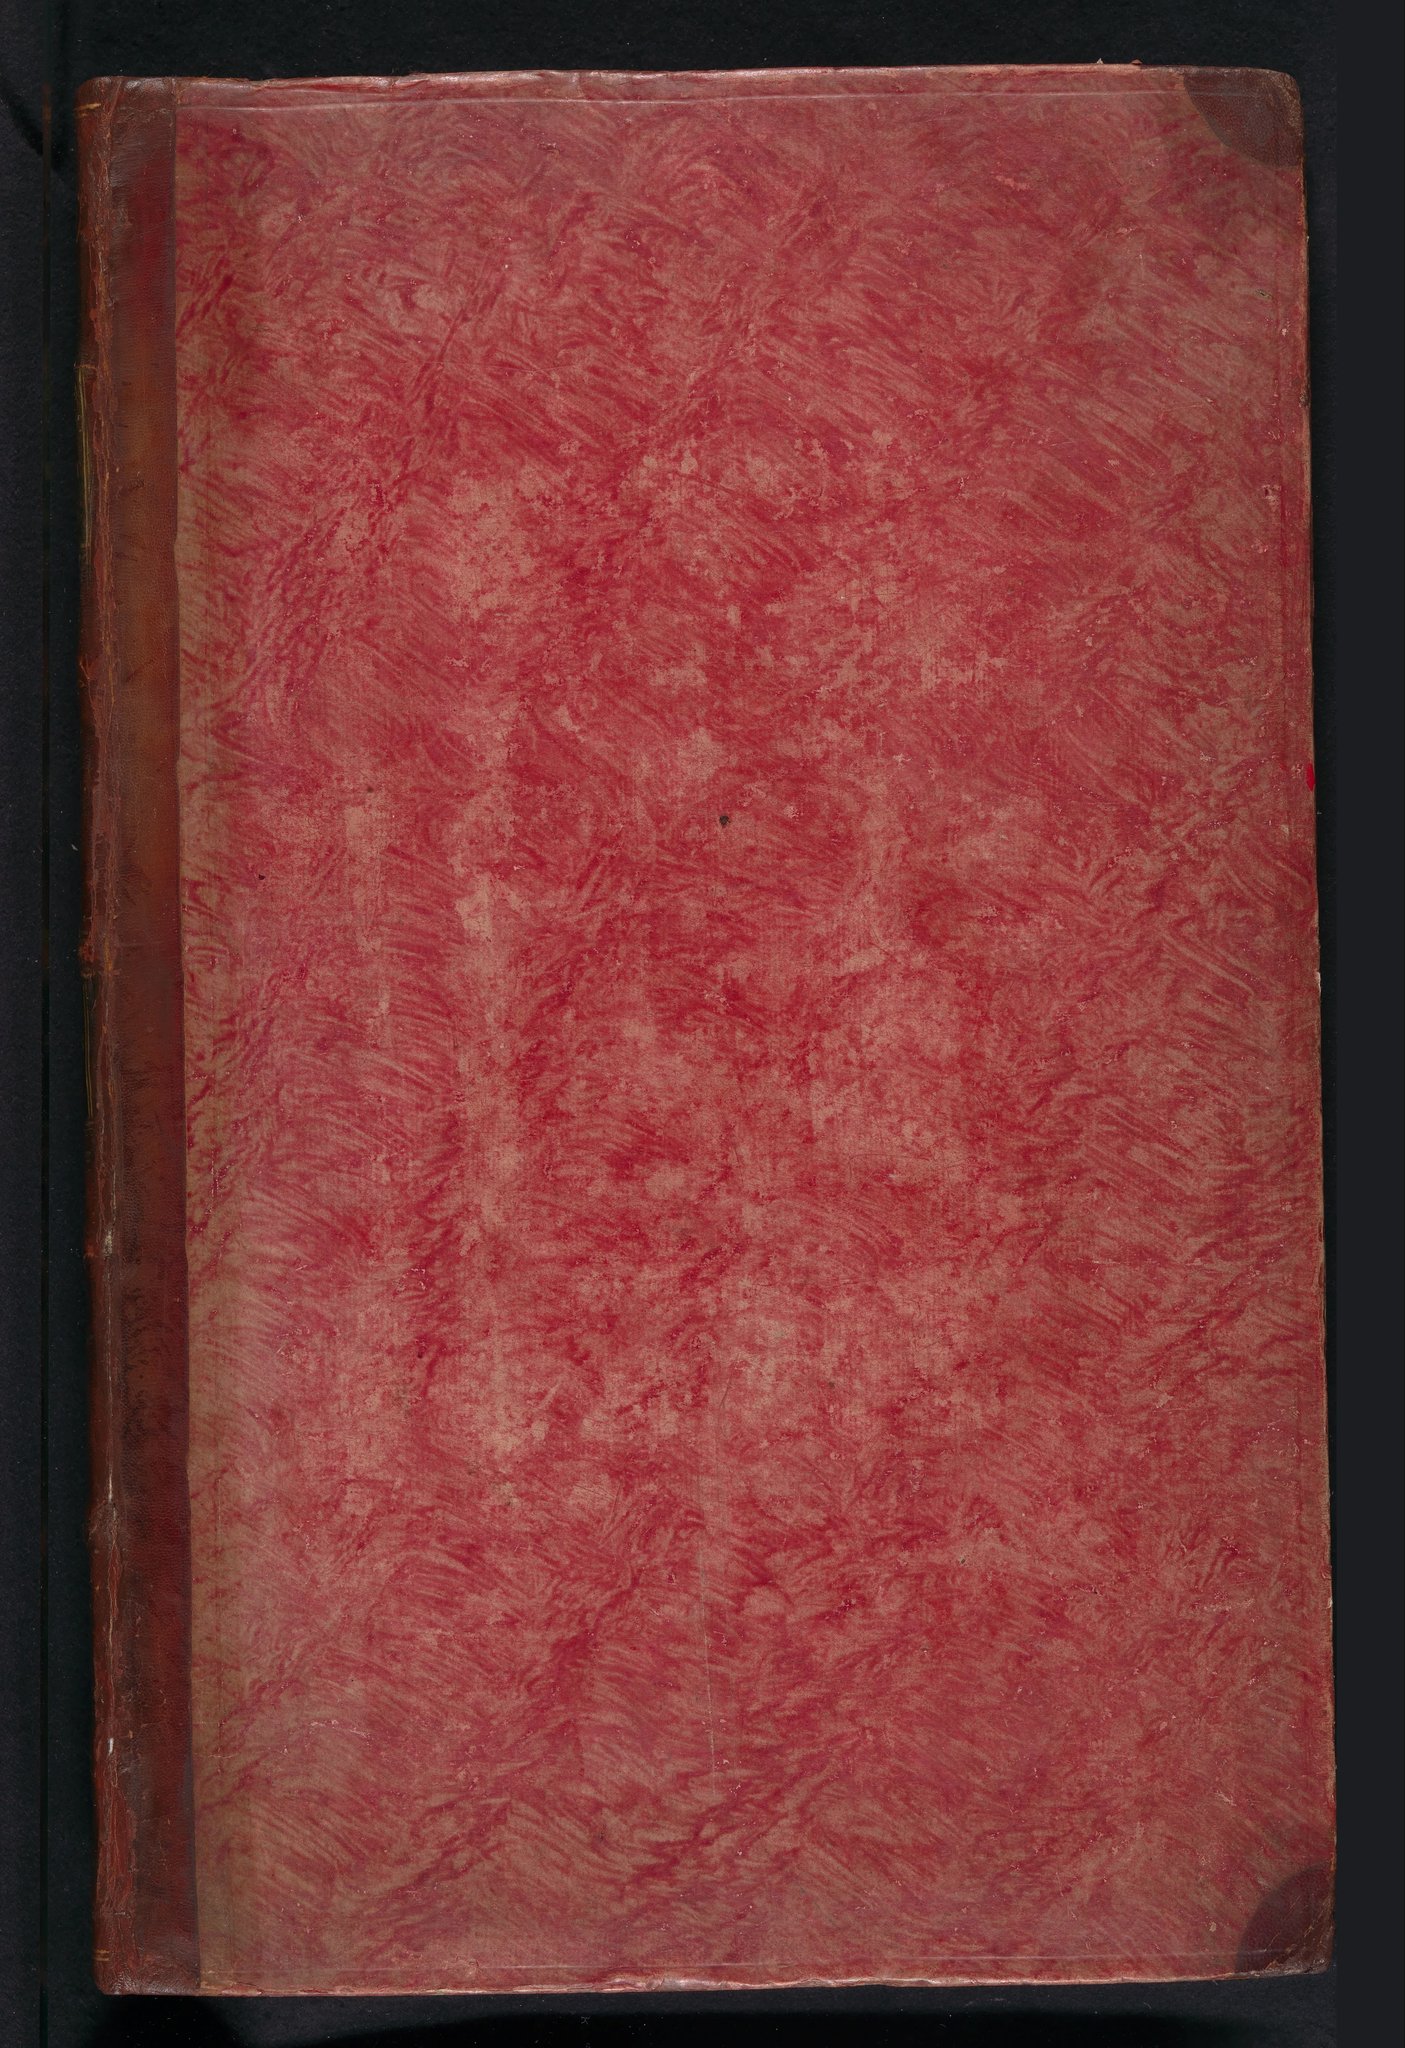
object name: album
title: Historia Naturalis van Rudolf II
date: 1596-1610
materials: leather, paper, watercolor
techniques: bookbinding, brush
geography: bruges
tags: vienna, prague, rudolf ii van habsburg (duits keizer)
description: Album met aquarellen van bloemen. Het tiende van twaalf albums met aquarellen van dieren, vogels en planten bekend rond 1600, gemaakt in opdracht van keizer Rudolf II. Met toelichting in Nederlands, Latijn en Frans.